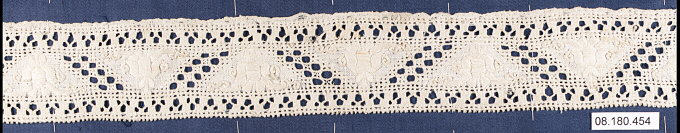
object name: border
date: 1501-1600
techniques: embroidery